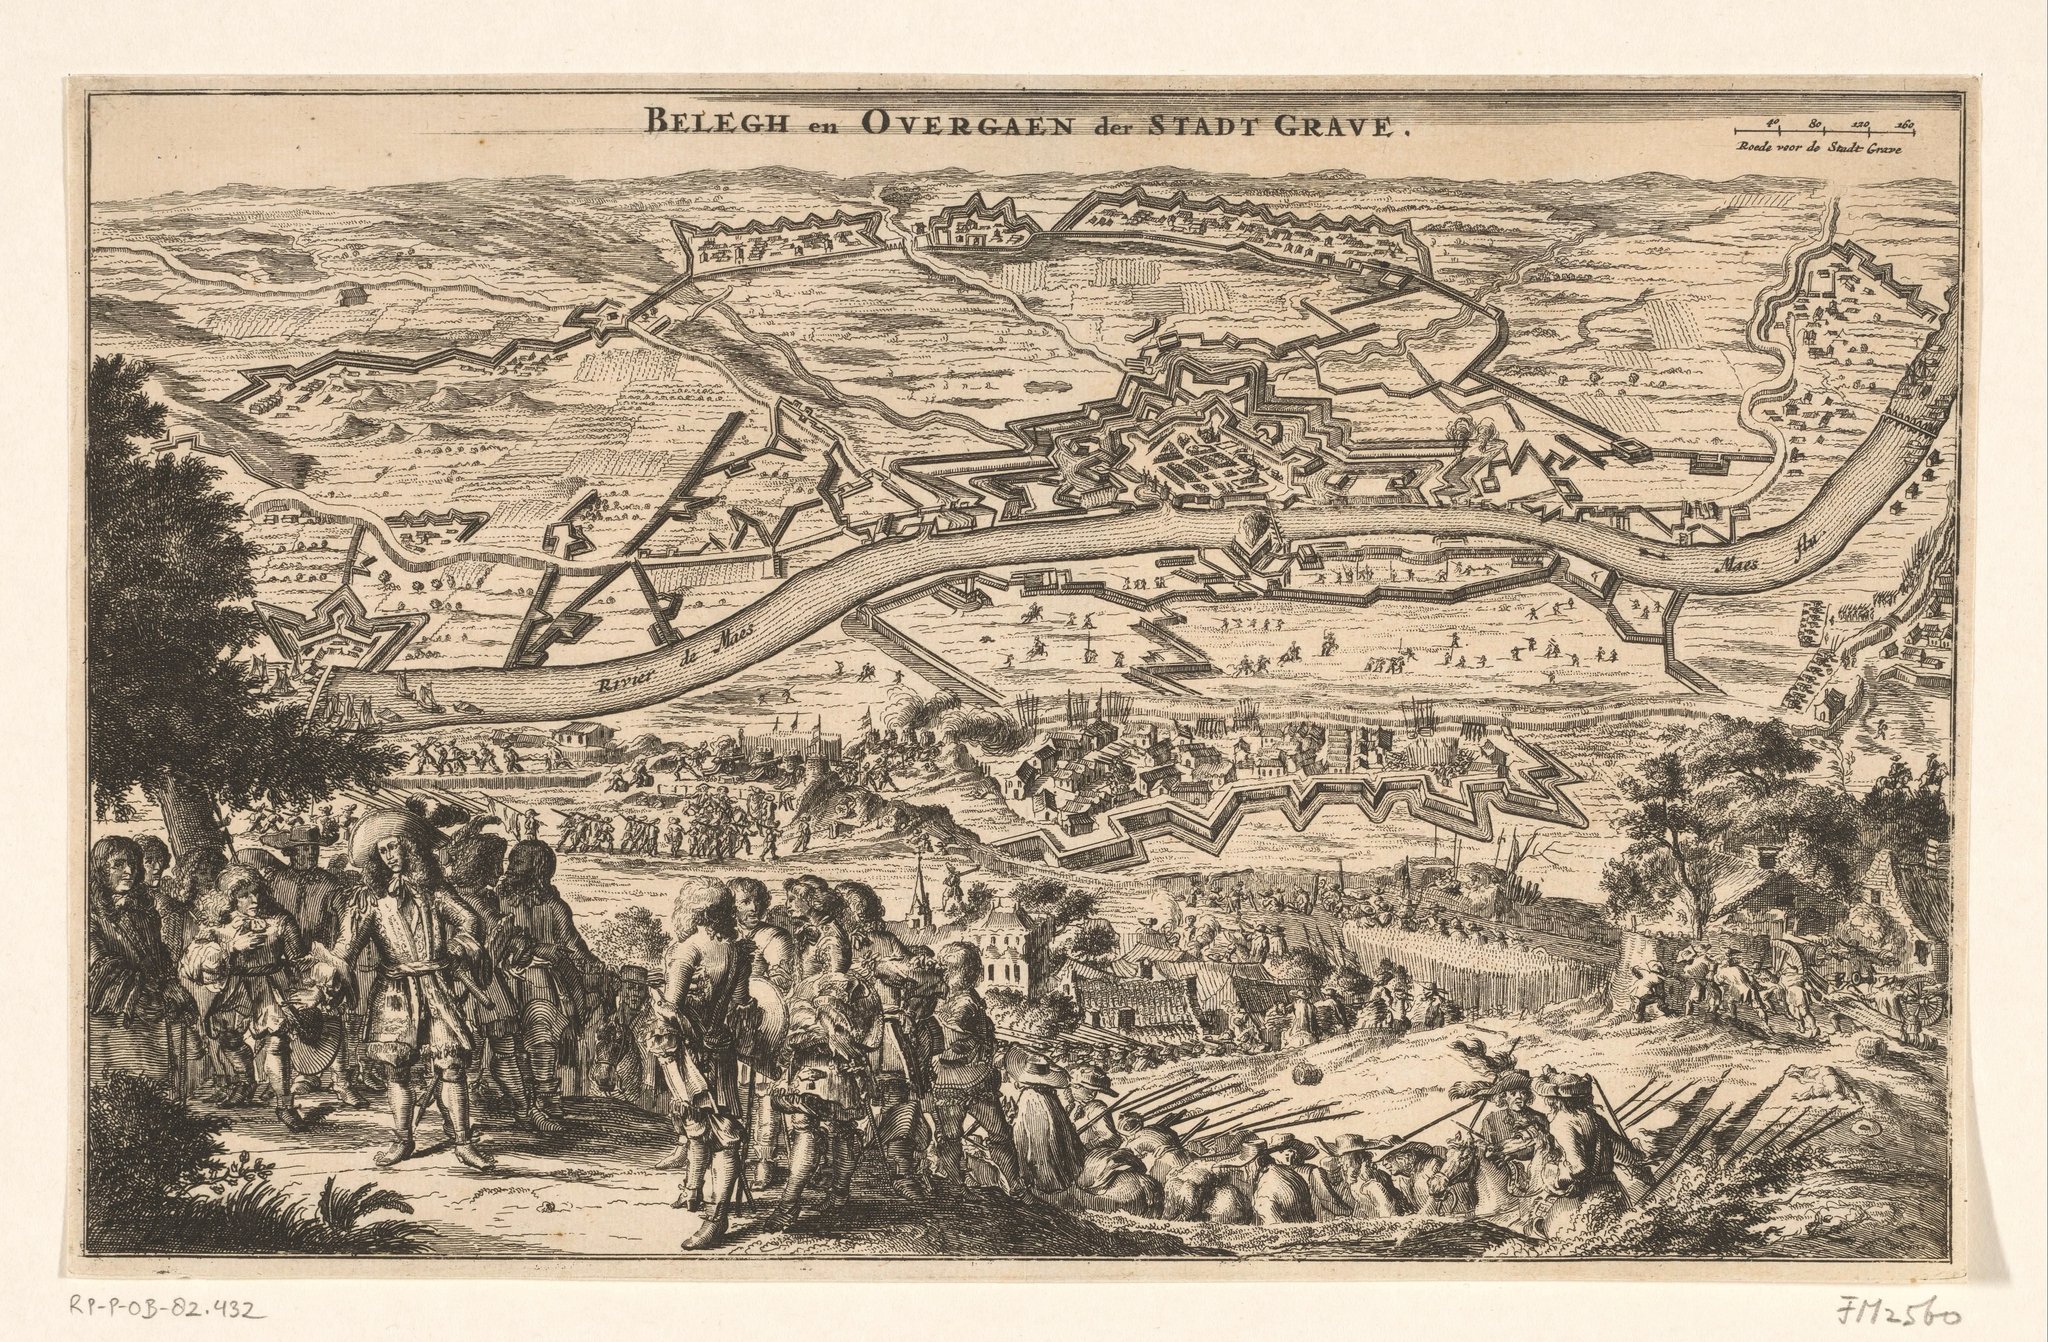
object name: print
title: Belegh en Overgaen der Stadt Grave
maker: Anonymous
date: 1674-1675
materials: paper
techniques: etching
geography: northern netherlands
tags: the hague, william iii (prince of orange and king of england, scotland, and ireland), siege, position war, grave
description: Kopie naar de prent van Romeyn de Hooghe, FMH 2559. Gebruikt als illustratie in: Lambert van den Bosch, Tooneel des oorlogs, opgerecht in de Vereenigde Nederlanden door de wapenen van de koningen van Vrankryk en Engeland, Keulsche en Munstersche bisschoppen : tegen de Staten der Vereenigde Nederlanden, en hare geallieerden, J. van Meurs en J. van Someren, Amsterdam 1675, 4 delen, dl. 4, fol. 302.